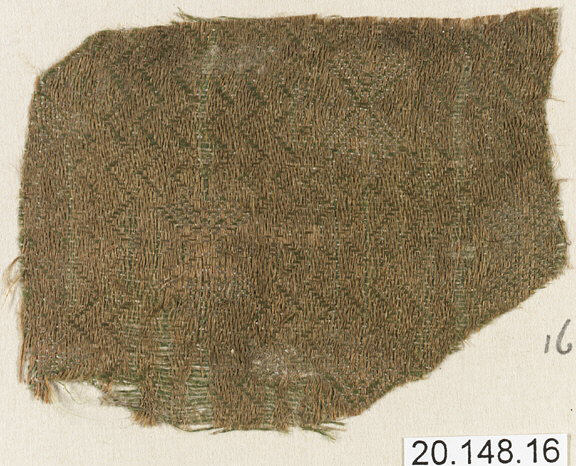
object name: piece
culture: japanese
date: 1101-1200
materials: silk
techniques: compound weave